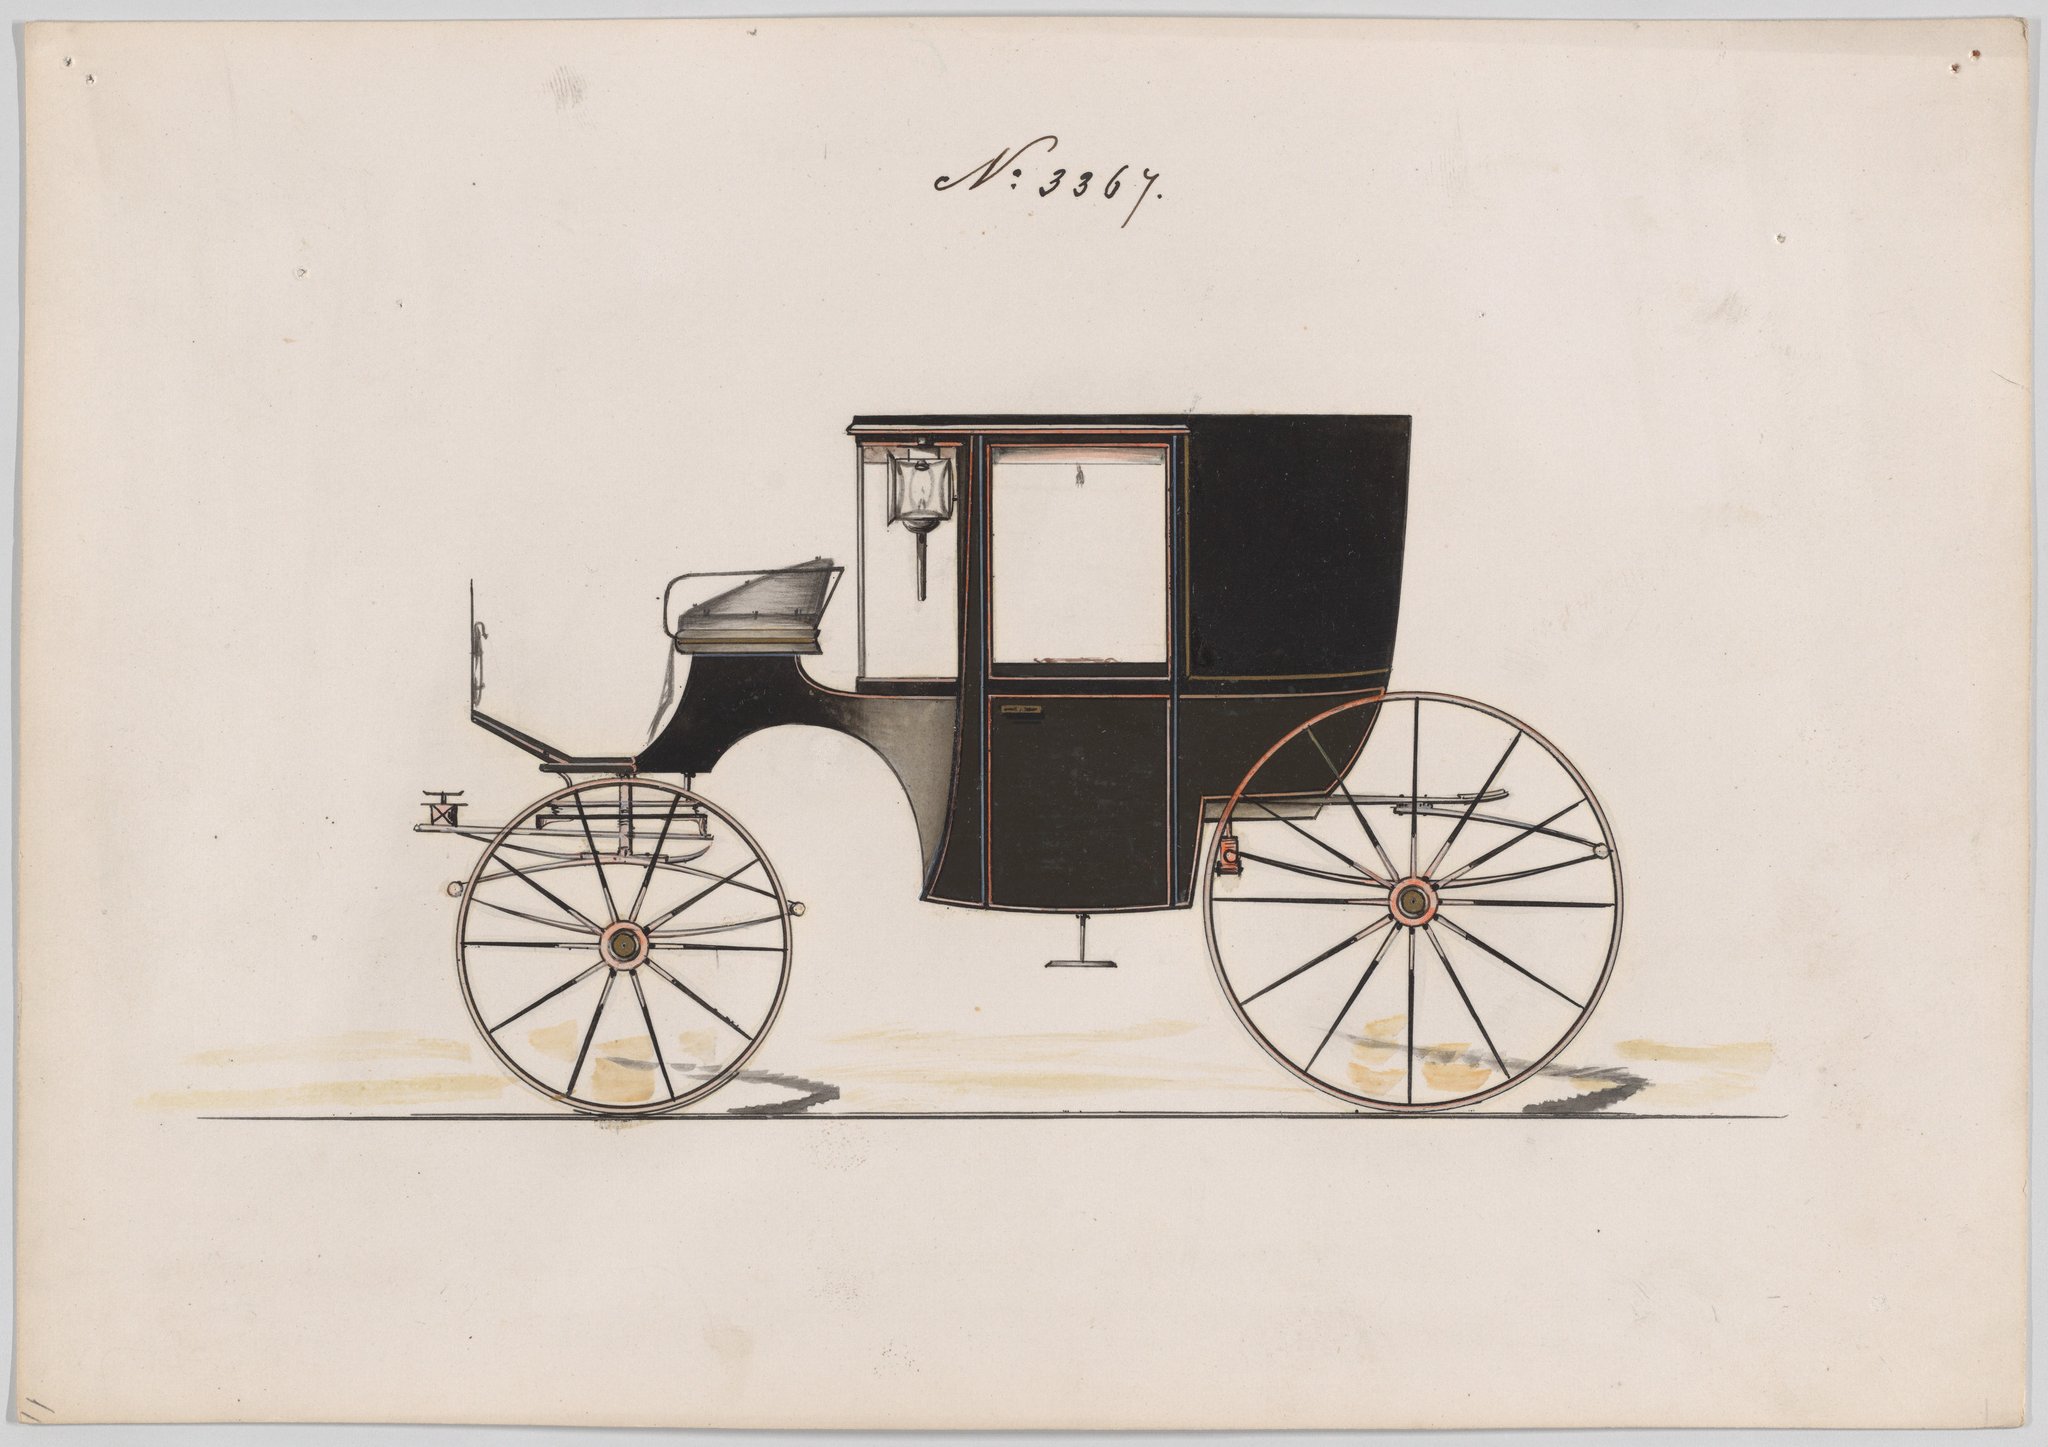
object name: drawing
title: Design for Coupé, no. 3367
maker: brewster & co.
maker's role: manufacturer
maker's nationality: american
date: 1877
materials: gouache, gum arabic, ink, watercolor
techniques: pen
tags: carriages